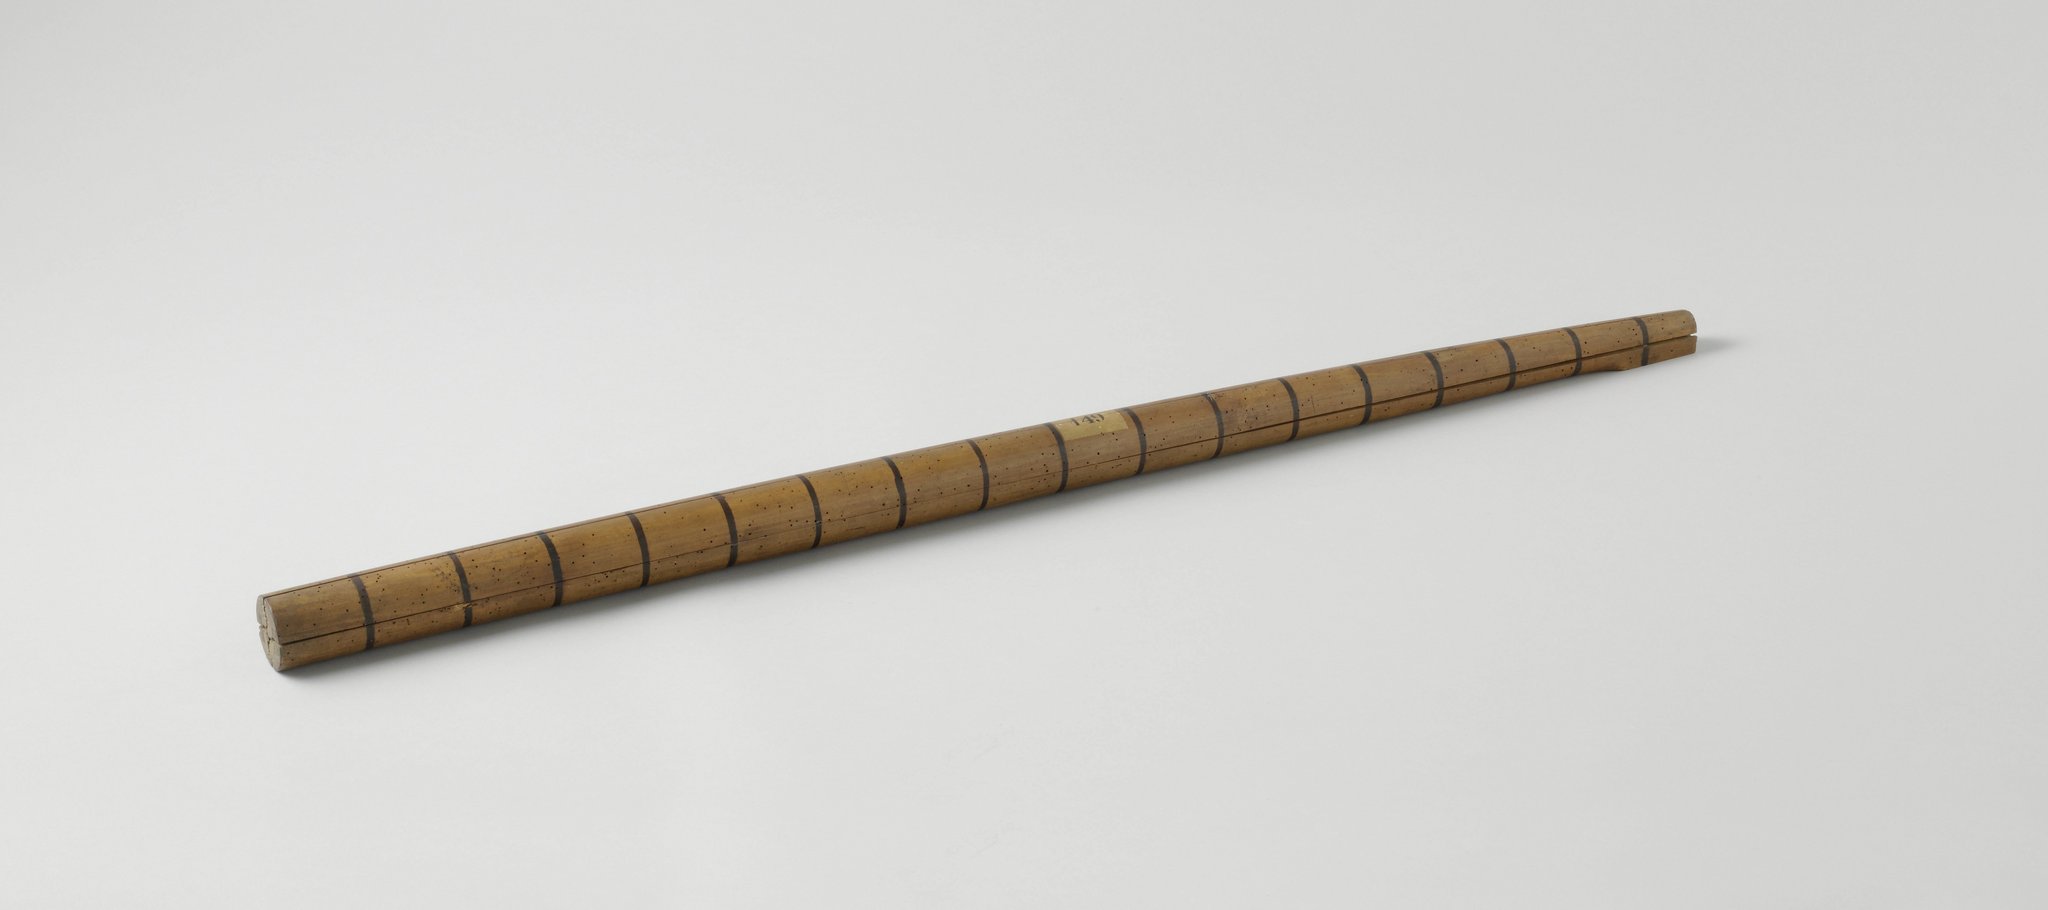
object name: demonstration model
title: Model of a Made Bowsprit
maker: Anonymous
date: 1800-1850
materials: wood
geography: netherlands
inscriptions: label: ‘149’ former inventory label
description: Model van een ronde boegspriet uit vier stukken bestaande, die binnenin met geschakelde liplassen zijn verbonden. Het eind is aan de bovenzijde afgevlakt. De kuipbanden zijn opgeschilderd.